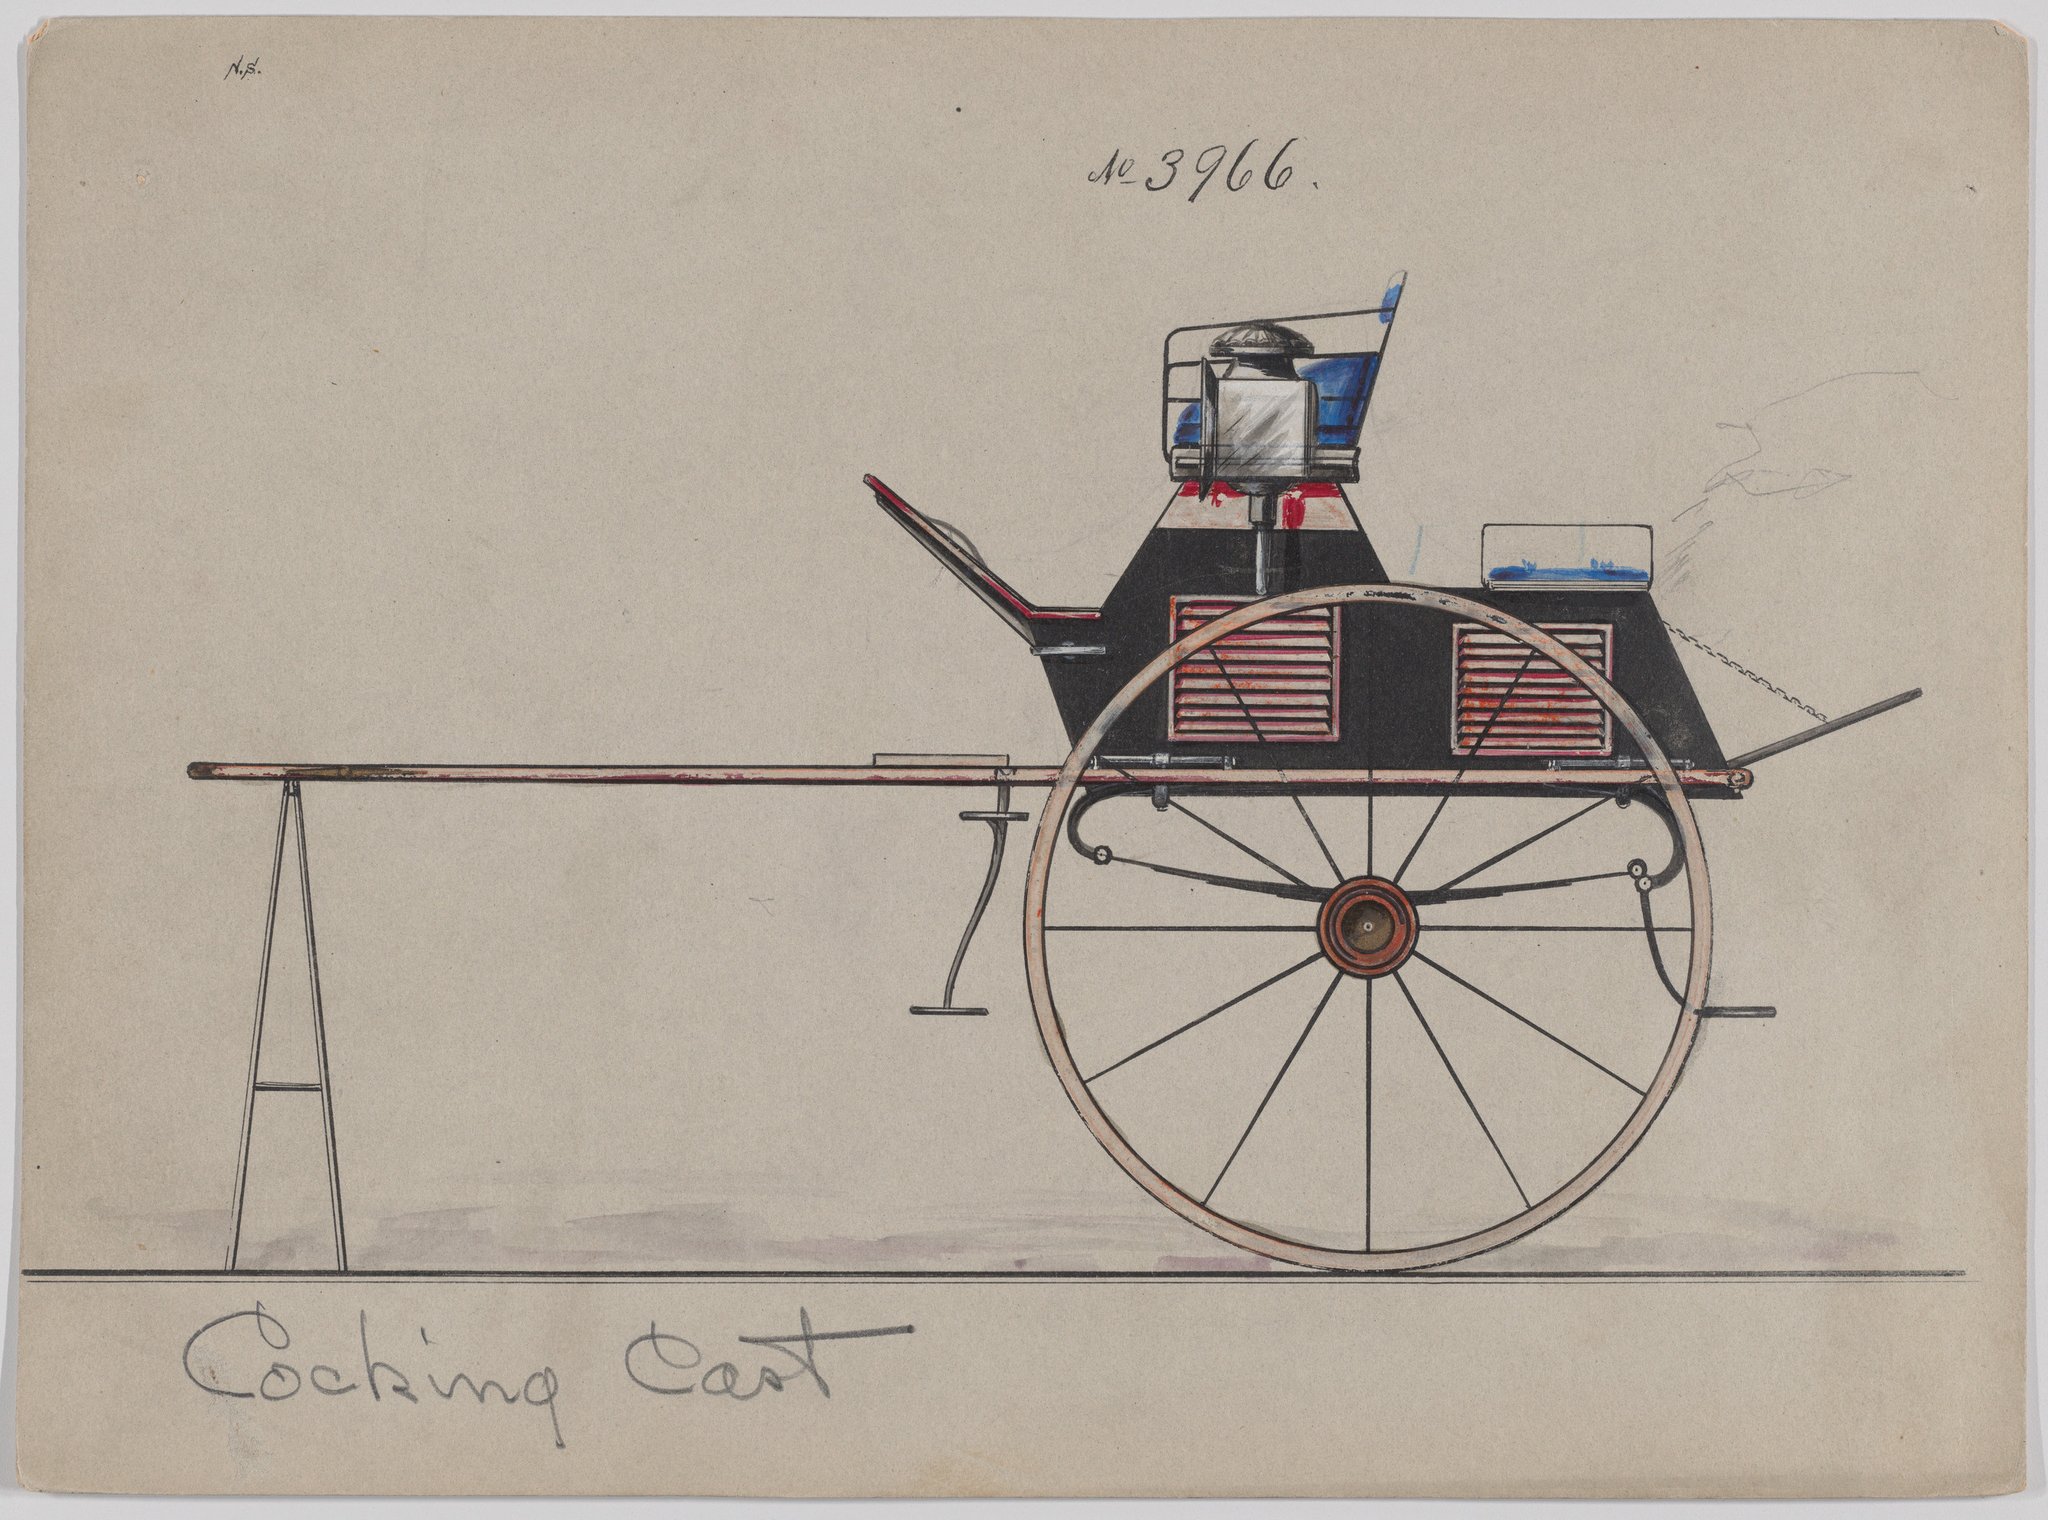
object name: drawing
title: Design for Dog Cart or 2 Wheeler, no. 3966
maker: brewster & co.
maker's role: manufacturer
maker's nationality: american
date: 1886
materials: gouache, gum arabic, ink, watercolor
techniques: pen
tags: carriages